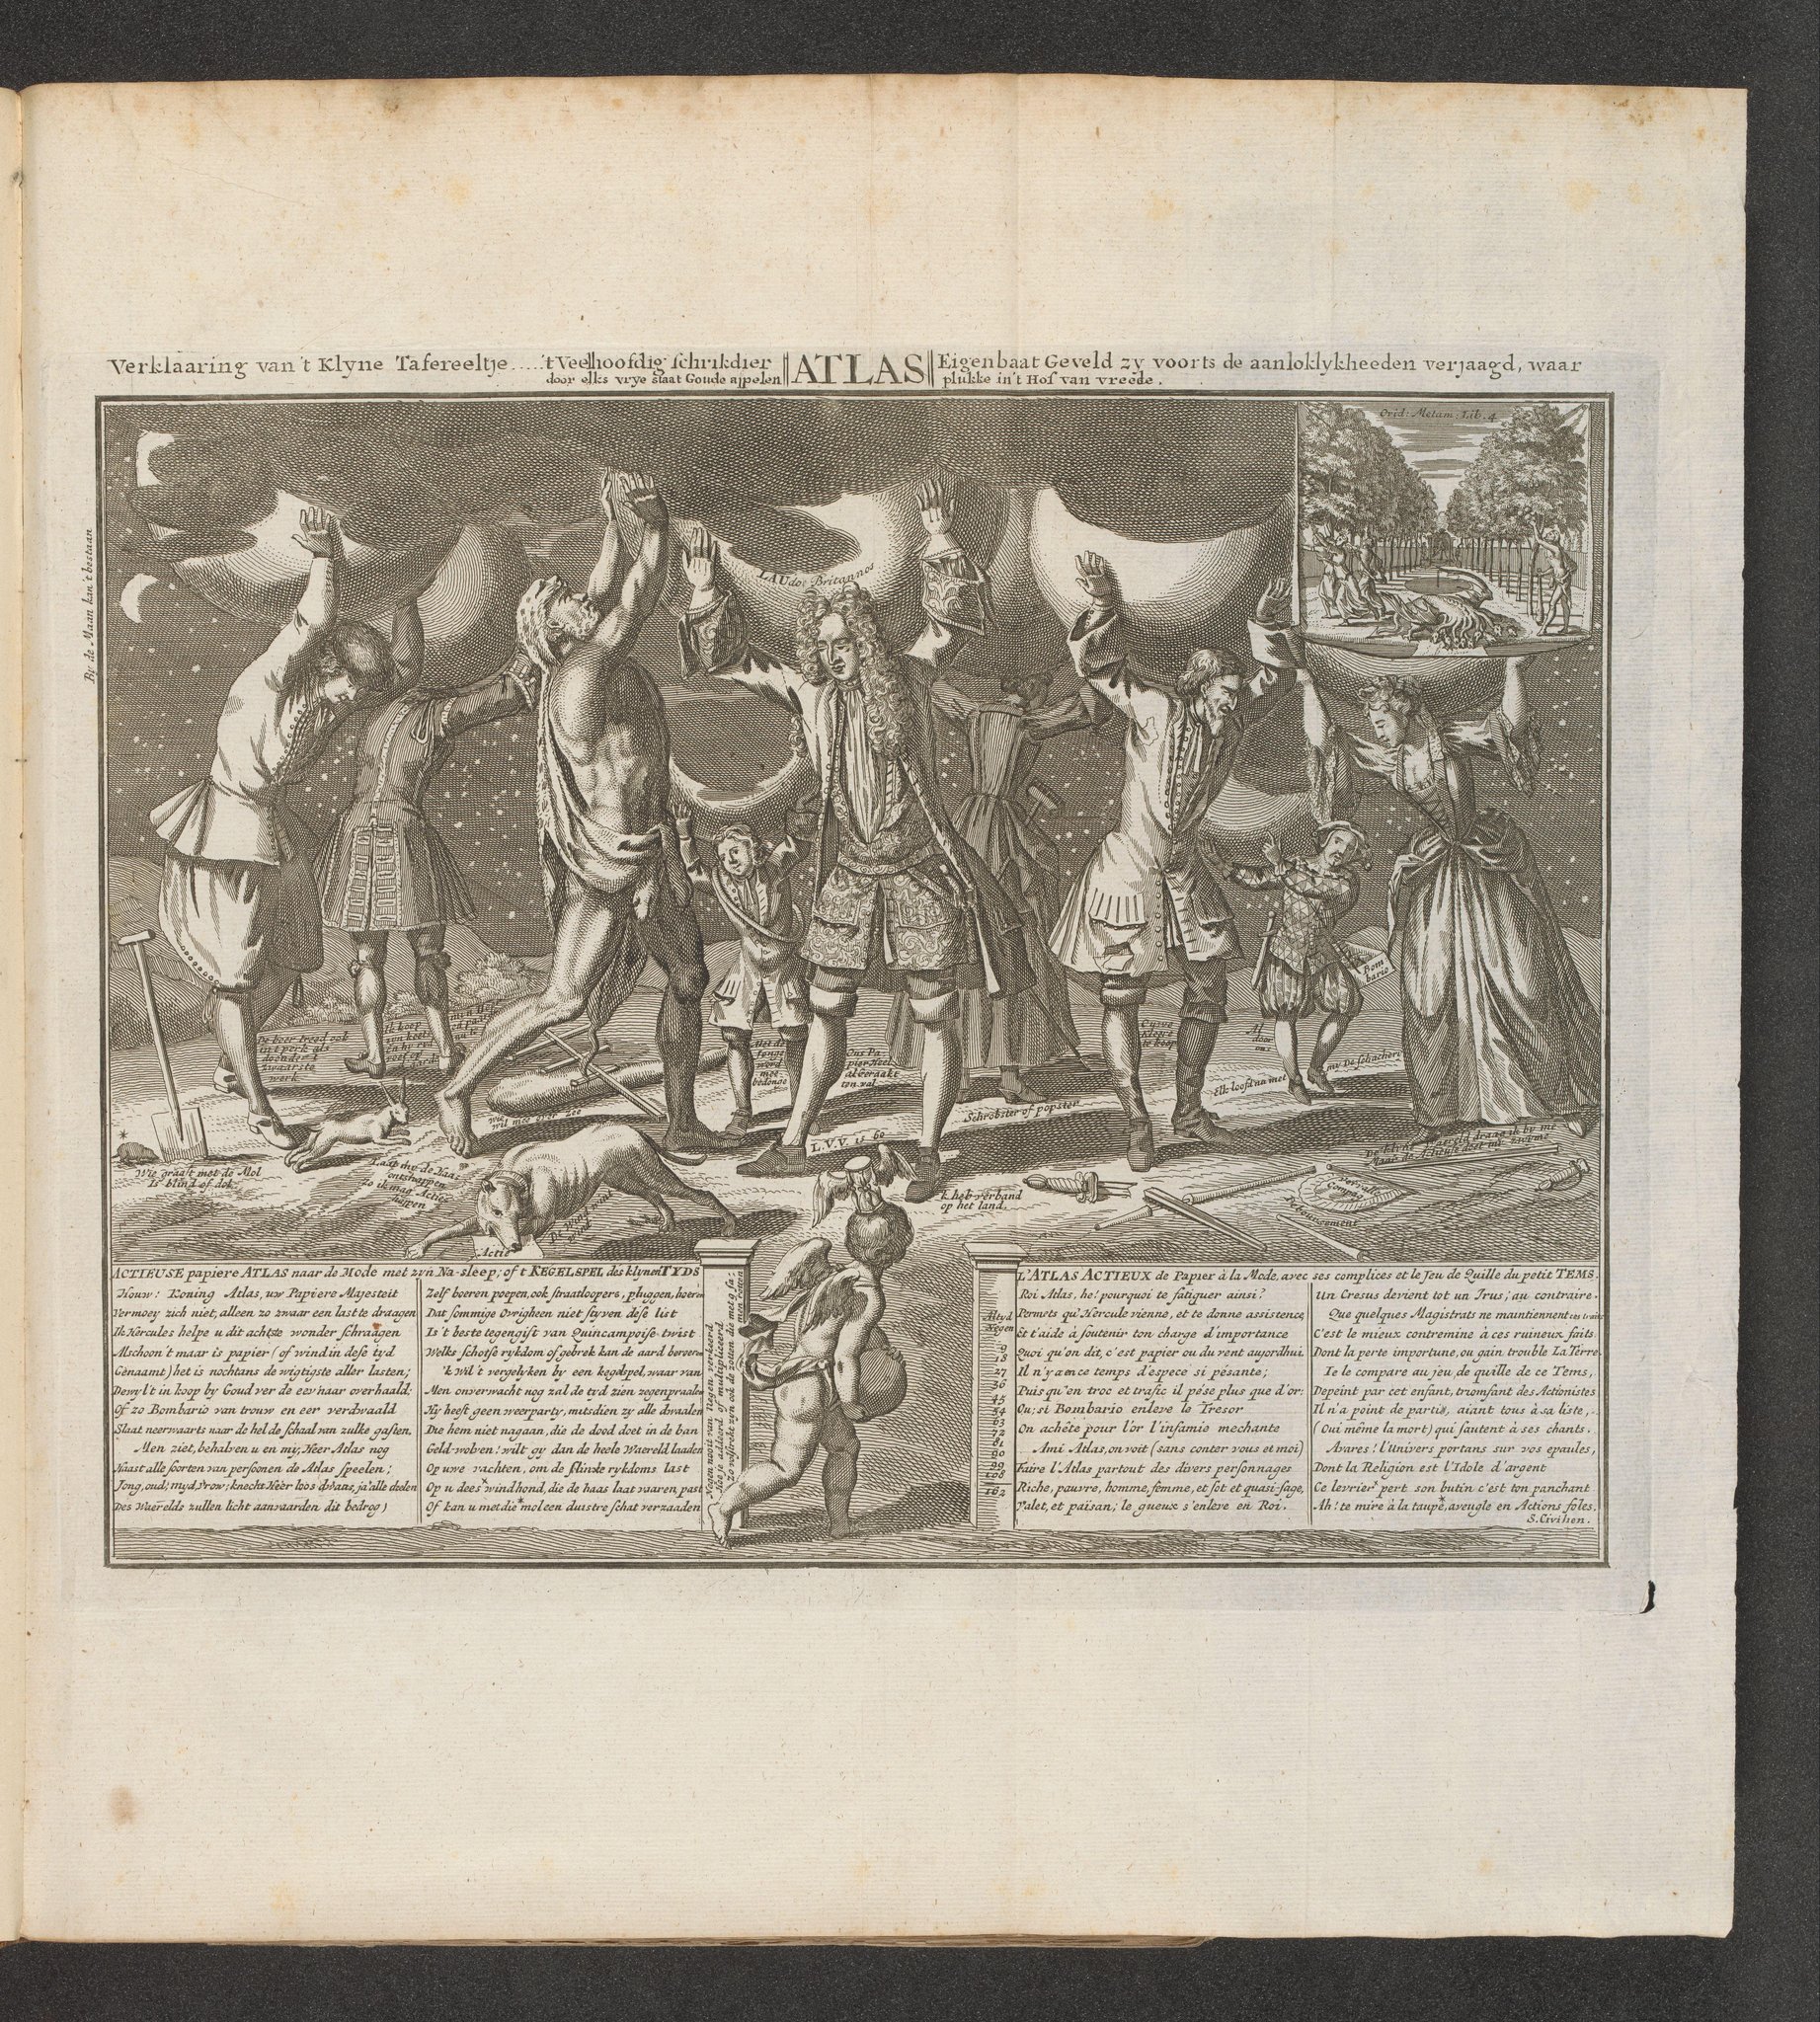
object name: print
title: Het Groote Tafereel der Dwaasheid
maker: Anonymous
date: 1720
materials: paper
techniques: etching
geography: northern netherlands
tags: atlas supporting the heavens on his shoulders, bowling games (children's games)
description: John Law en andere mannen en vrouwen torsen gelijk Atlas hun schulden als een enorme bol (met wind of papier) op hun schouders. Op de voorgrond staat de tijd klaar om met een bal de personen omver te kegelen. Met onderschriften in het Nederlands en Frans door S. Civilien. Prent in de gebonden vierde uitgave (304 B 12) van Het Groote Tafereel der Dwaasheid met spotprenten op de Windhandel of Actiehandel van 1720.